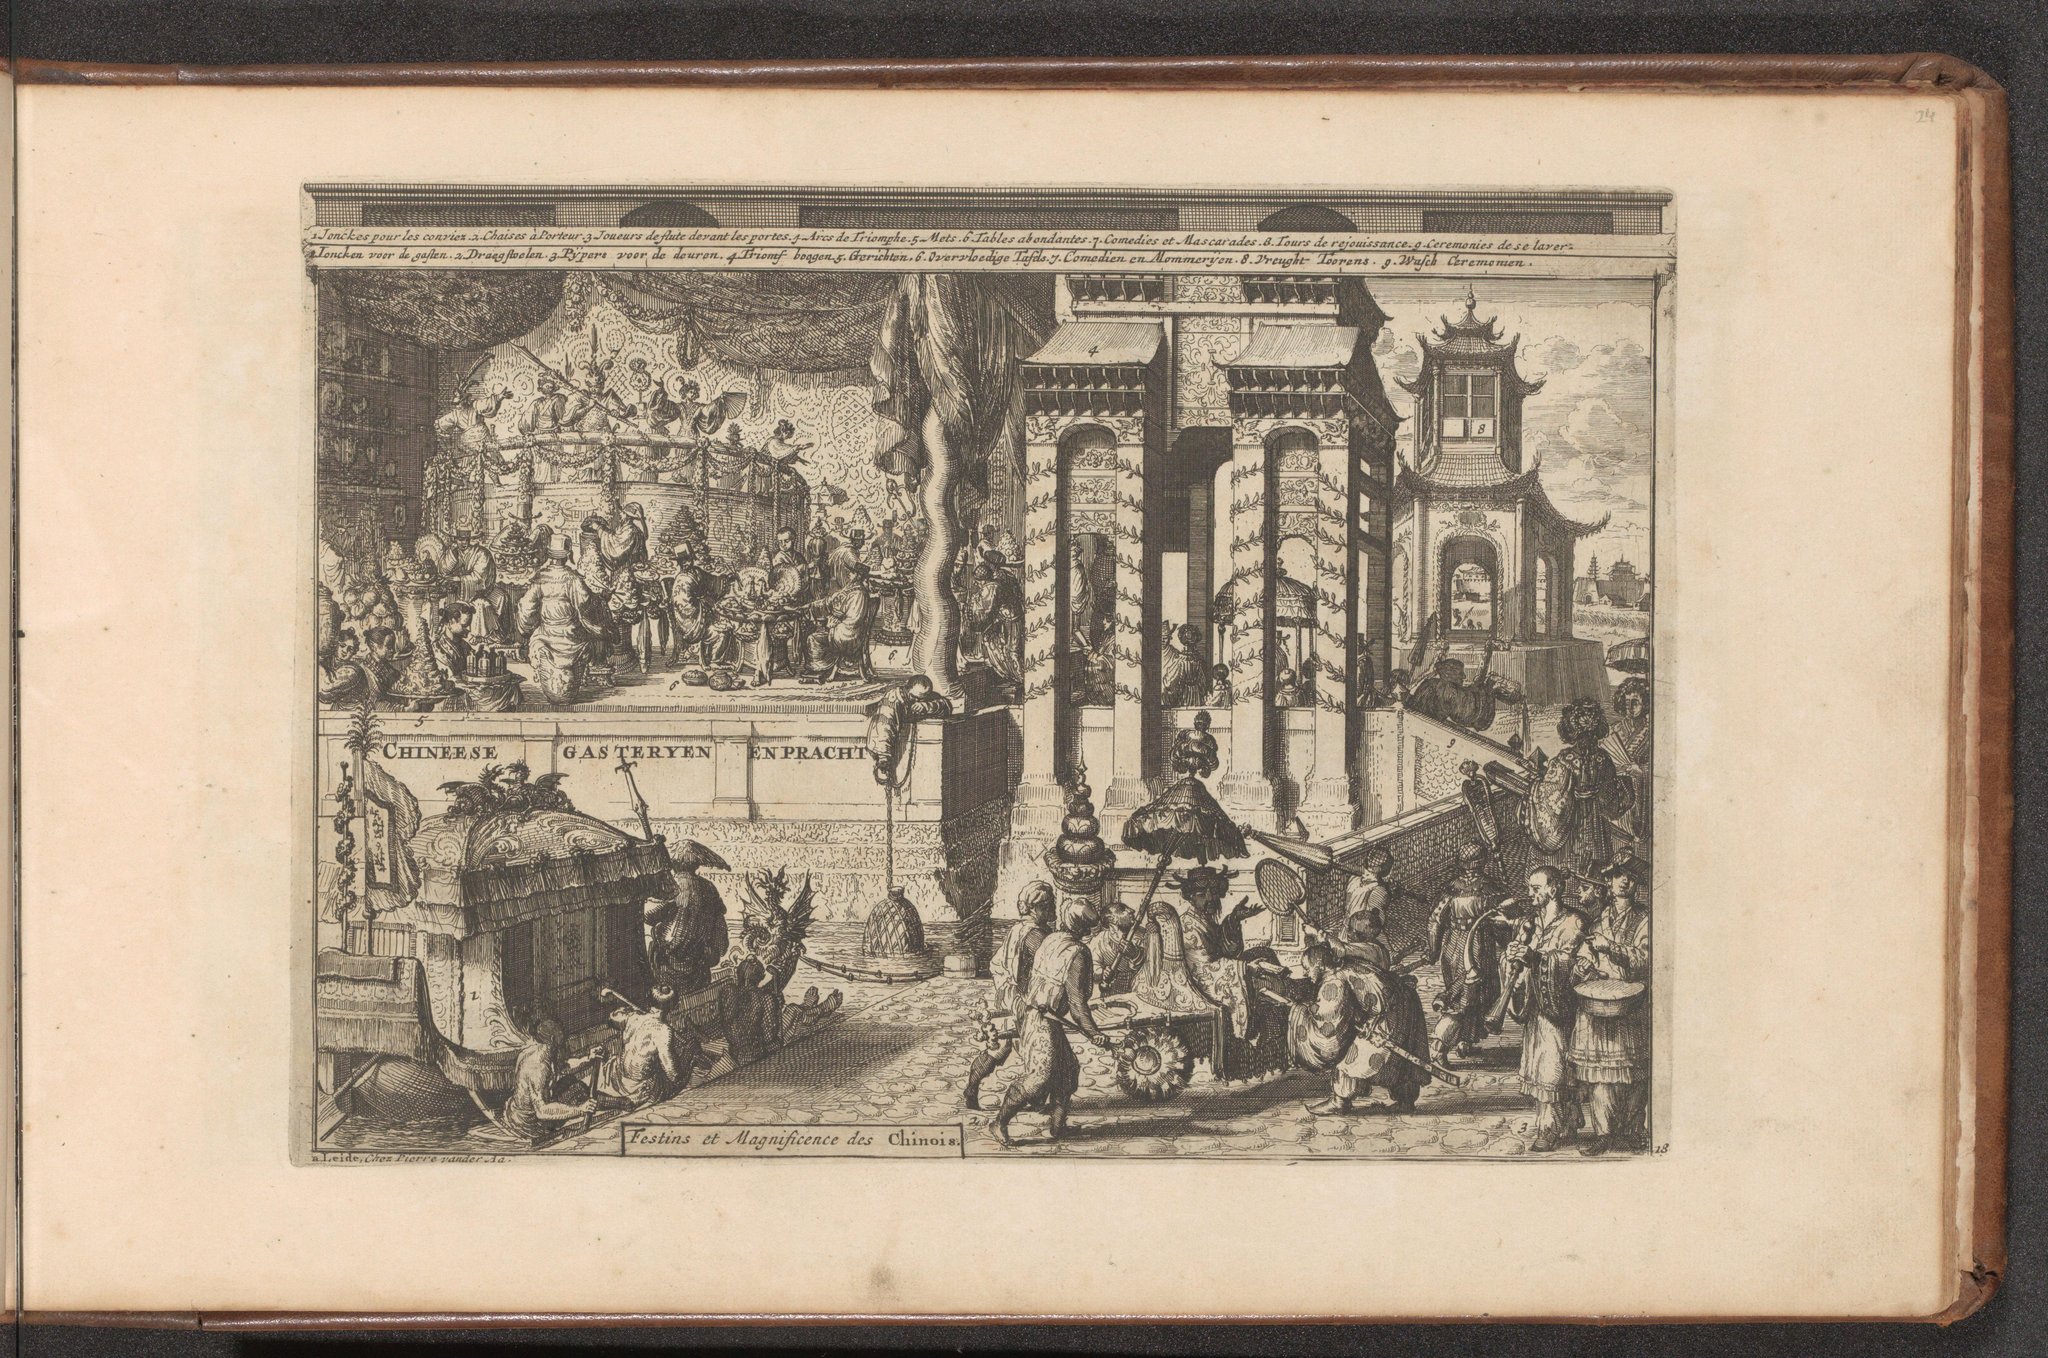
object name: print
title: Ontvangstceremonie bij de Chinezen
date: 1682-1733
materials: paper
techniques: etching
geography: leiden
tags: chinese, visiting; receiving guests; elegant company, (carrying a person in a) sedan-chair, celebration meal, feast, banquet, china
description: Ontvangstceremonie bij de Chinezen. Een Chinese gast is in een jonk of zeilschip naar de plek van bestemming gebracht en wordt in een draagstoel verder vervoerd. Muziekspelers verzorgen het onthaal. Linksboven een feestmaal en een toneelvoorstelling. Met een legenda in het Nederlands en het Frans. De prent maakt deel uit van een album.